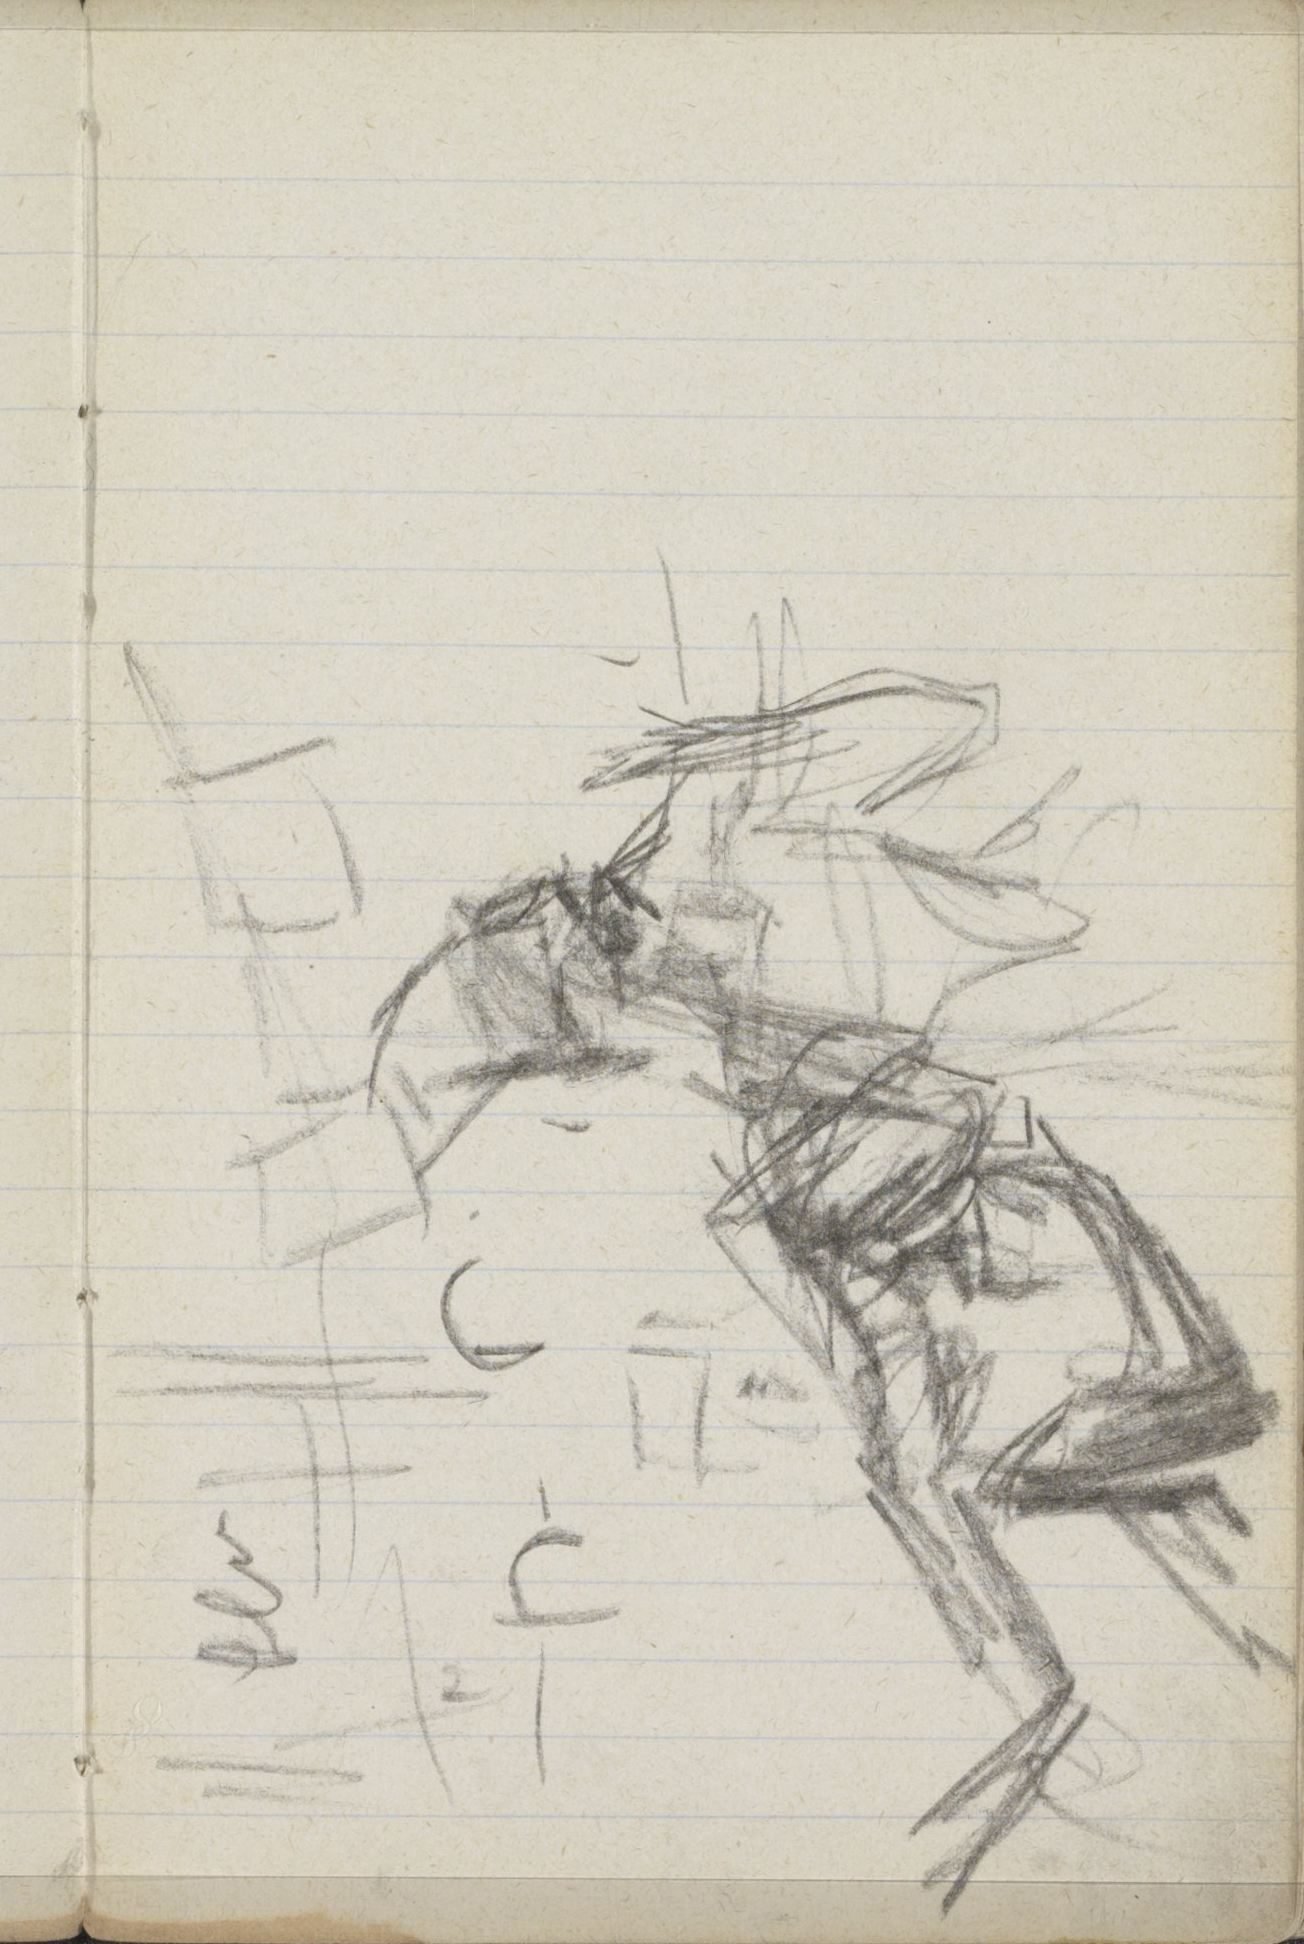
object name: sketchbook leaf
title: Studie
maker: george hendrik breitner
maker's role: draughtsman, painter, print maker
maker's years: 1857-1923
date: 1893-1898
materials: chalk, paper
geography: amsterdam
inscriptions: kleurnotitie, handgeschreven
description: Pagina 8 uit een schetsboek met 31 bladen.